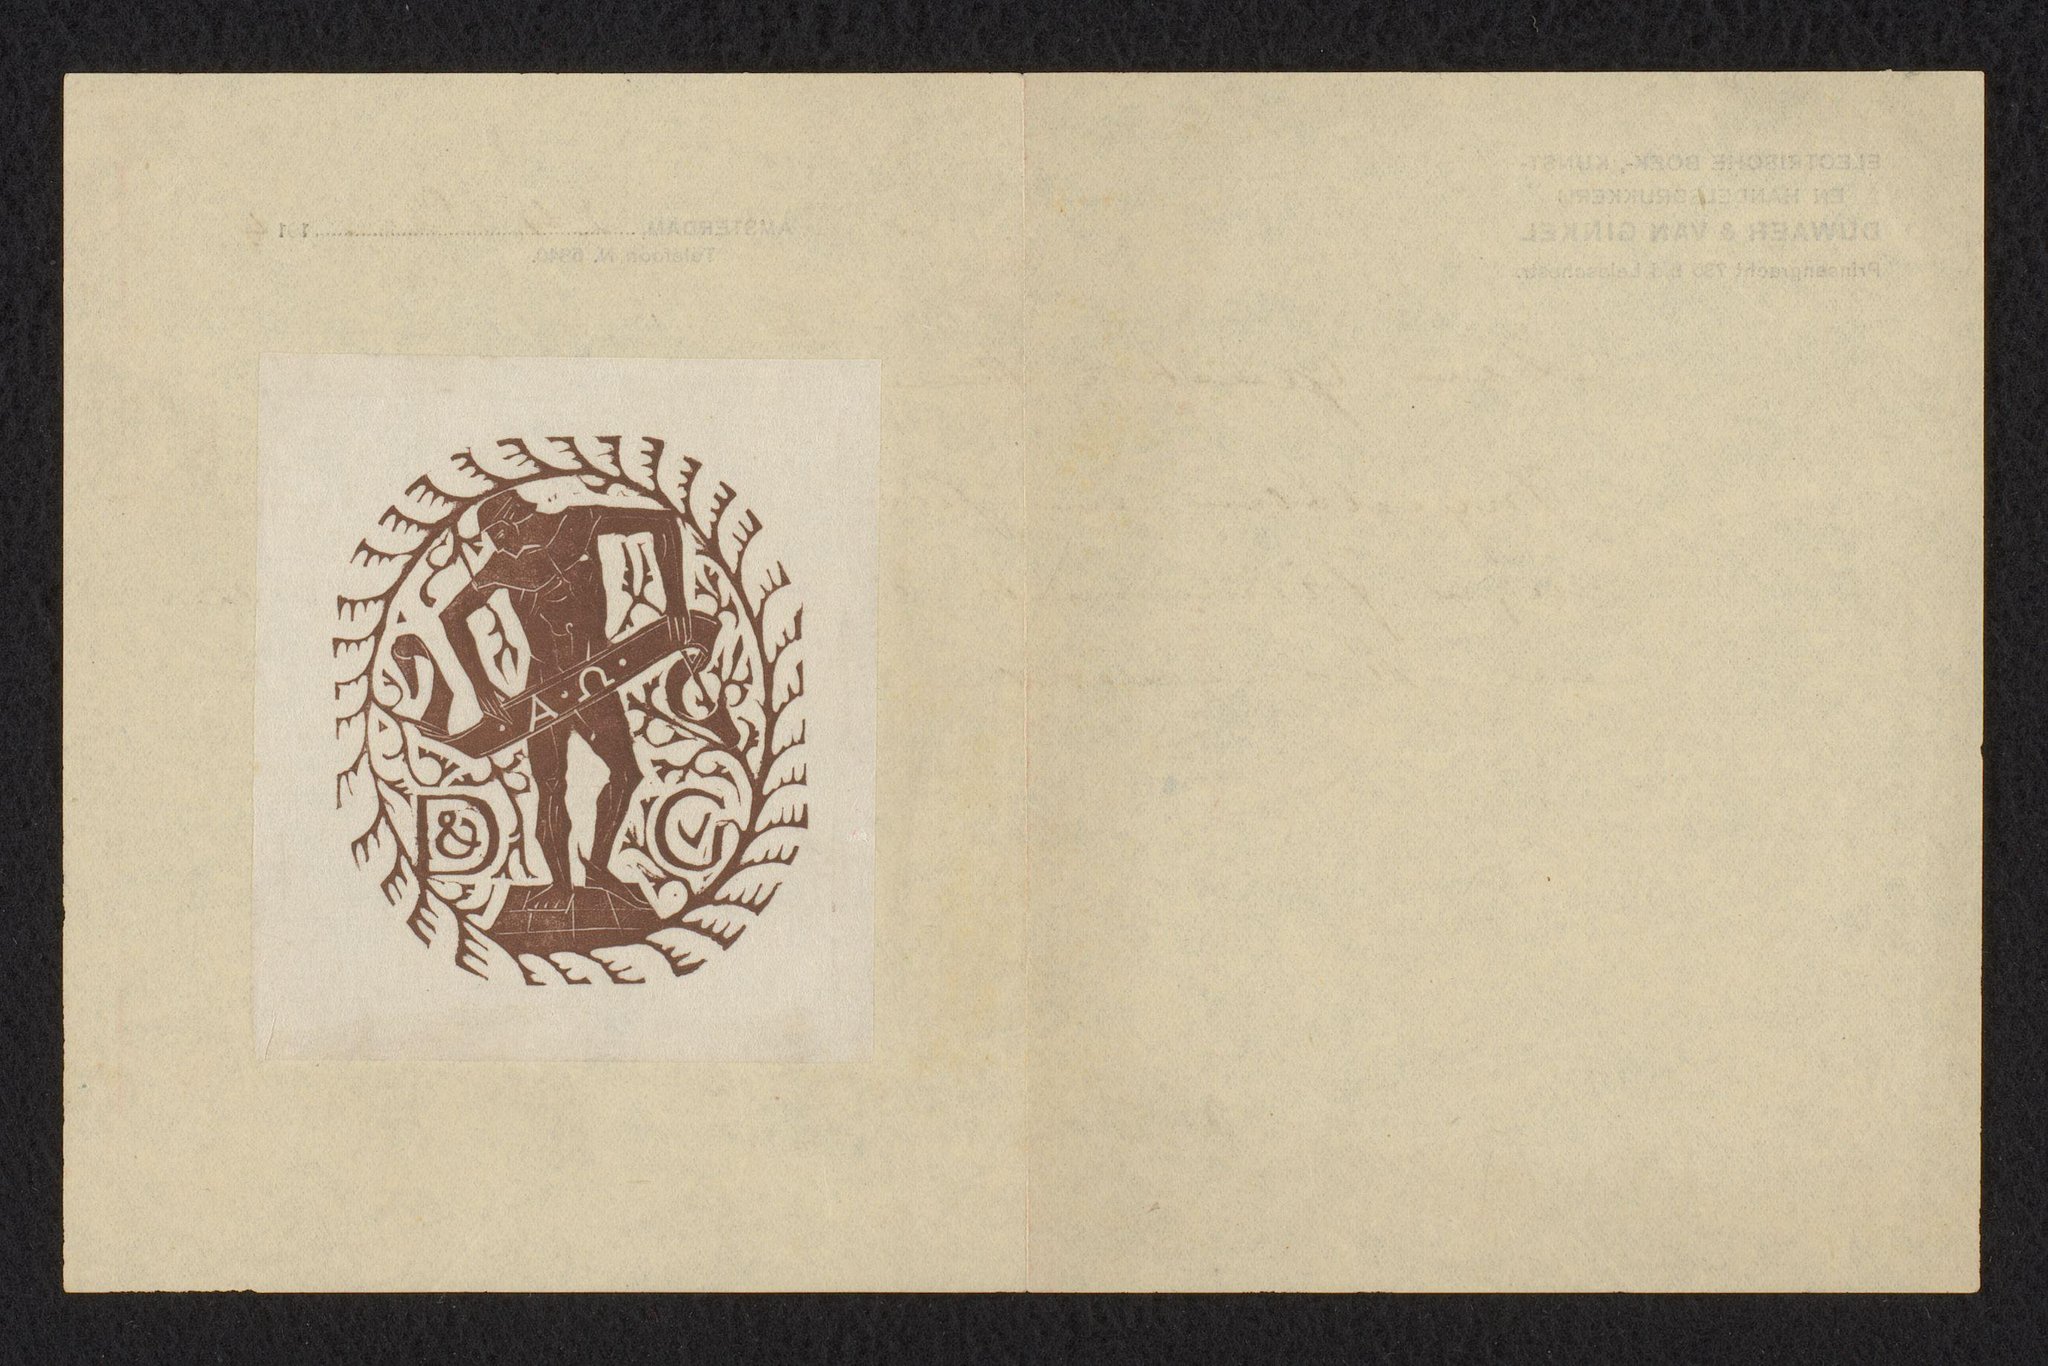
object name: print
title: Uitgeversvignet van Duwaer & Van Ginkel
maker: mathieu lauweriks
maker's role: designer, draughtsman, print maker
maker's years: 1864-1932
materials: ink, paper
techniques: letterpress printing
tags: device (trade-mark of printer or publisher), publishing, publisher, letter, envelope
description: Op het verso, onder het briefhoofd van 'Electrische boek-, kunst- en handelsdrukkerij Duwaer & Van Ginkel', gedateerd 24 december 1914, een korte tekst in handschrift van de uitgever Duwaer: 'Ingesloten een paar afdrukjes van mijn firmamerk [...] Uw dz. Duwaer'.